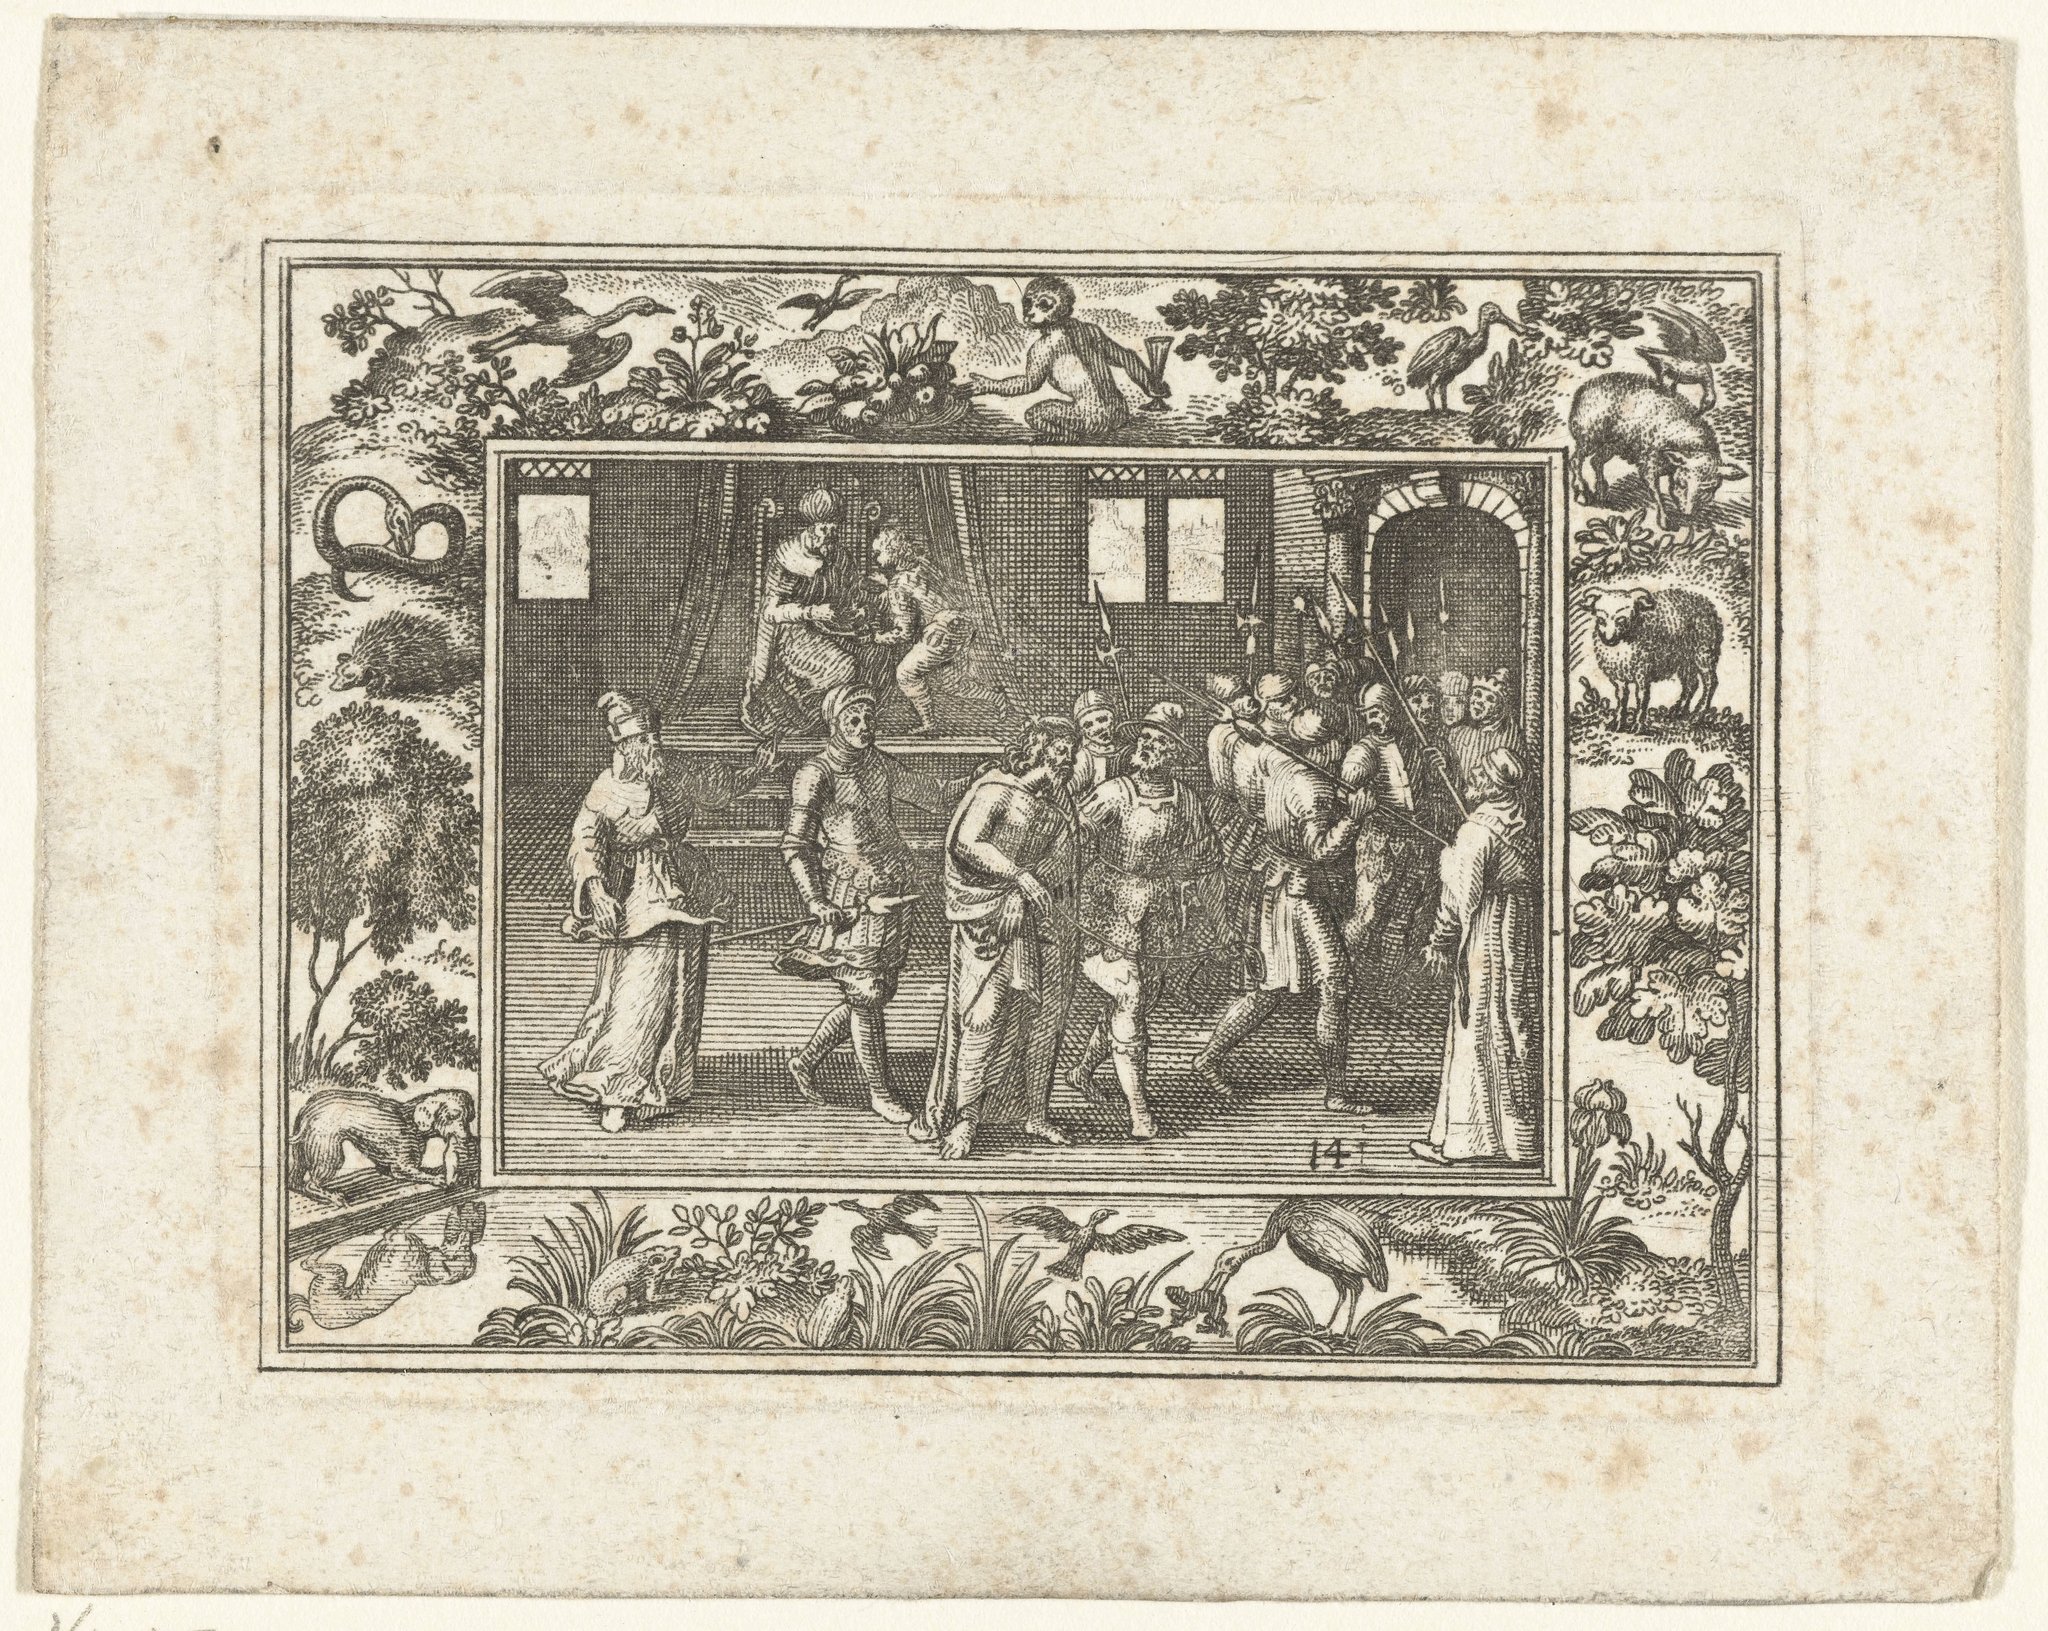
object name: print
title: Passievoorstellingen in lijsten met dieren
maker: Anonymous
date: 1600-1699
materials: paper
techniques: etching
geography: germany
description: Midden boven zit een aapje, rechtsonder vangt een reiger een kikker.